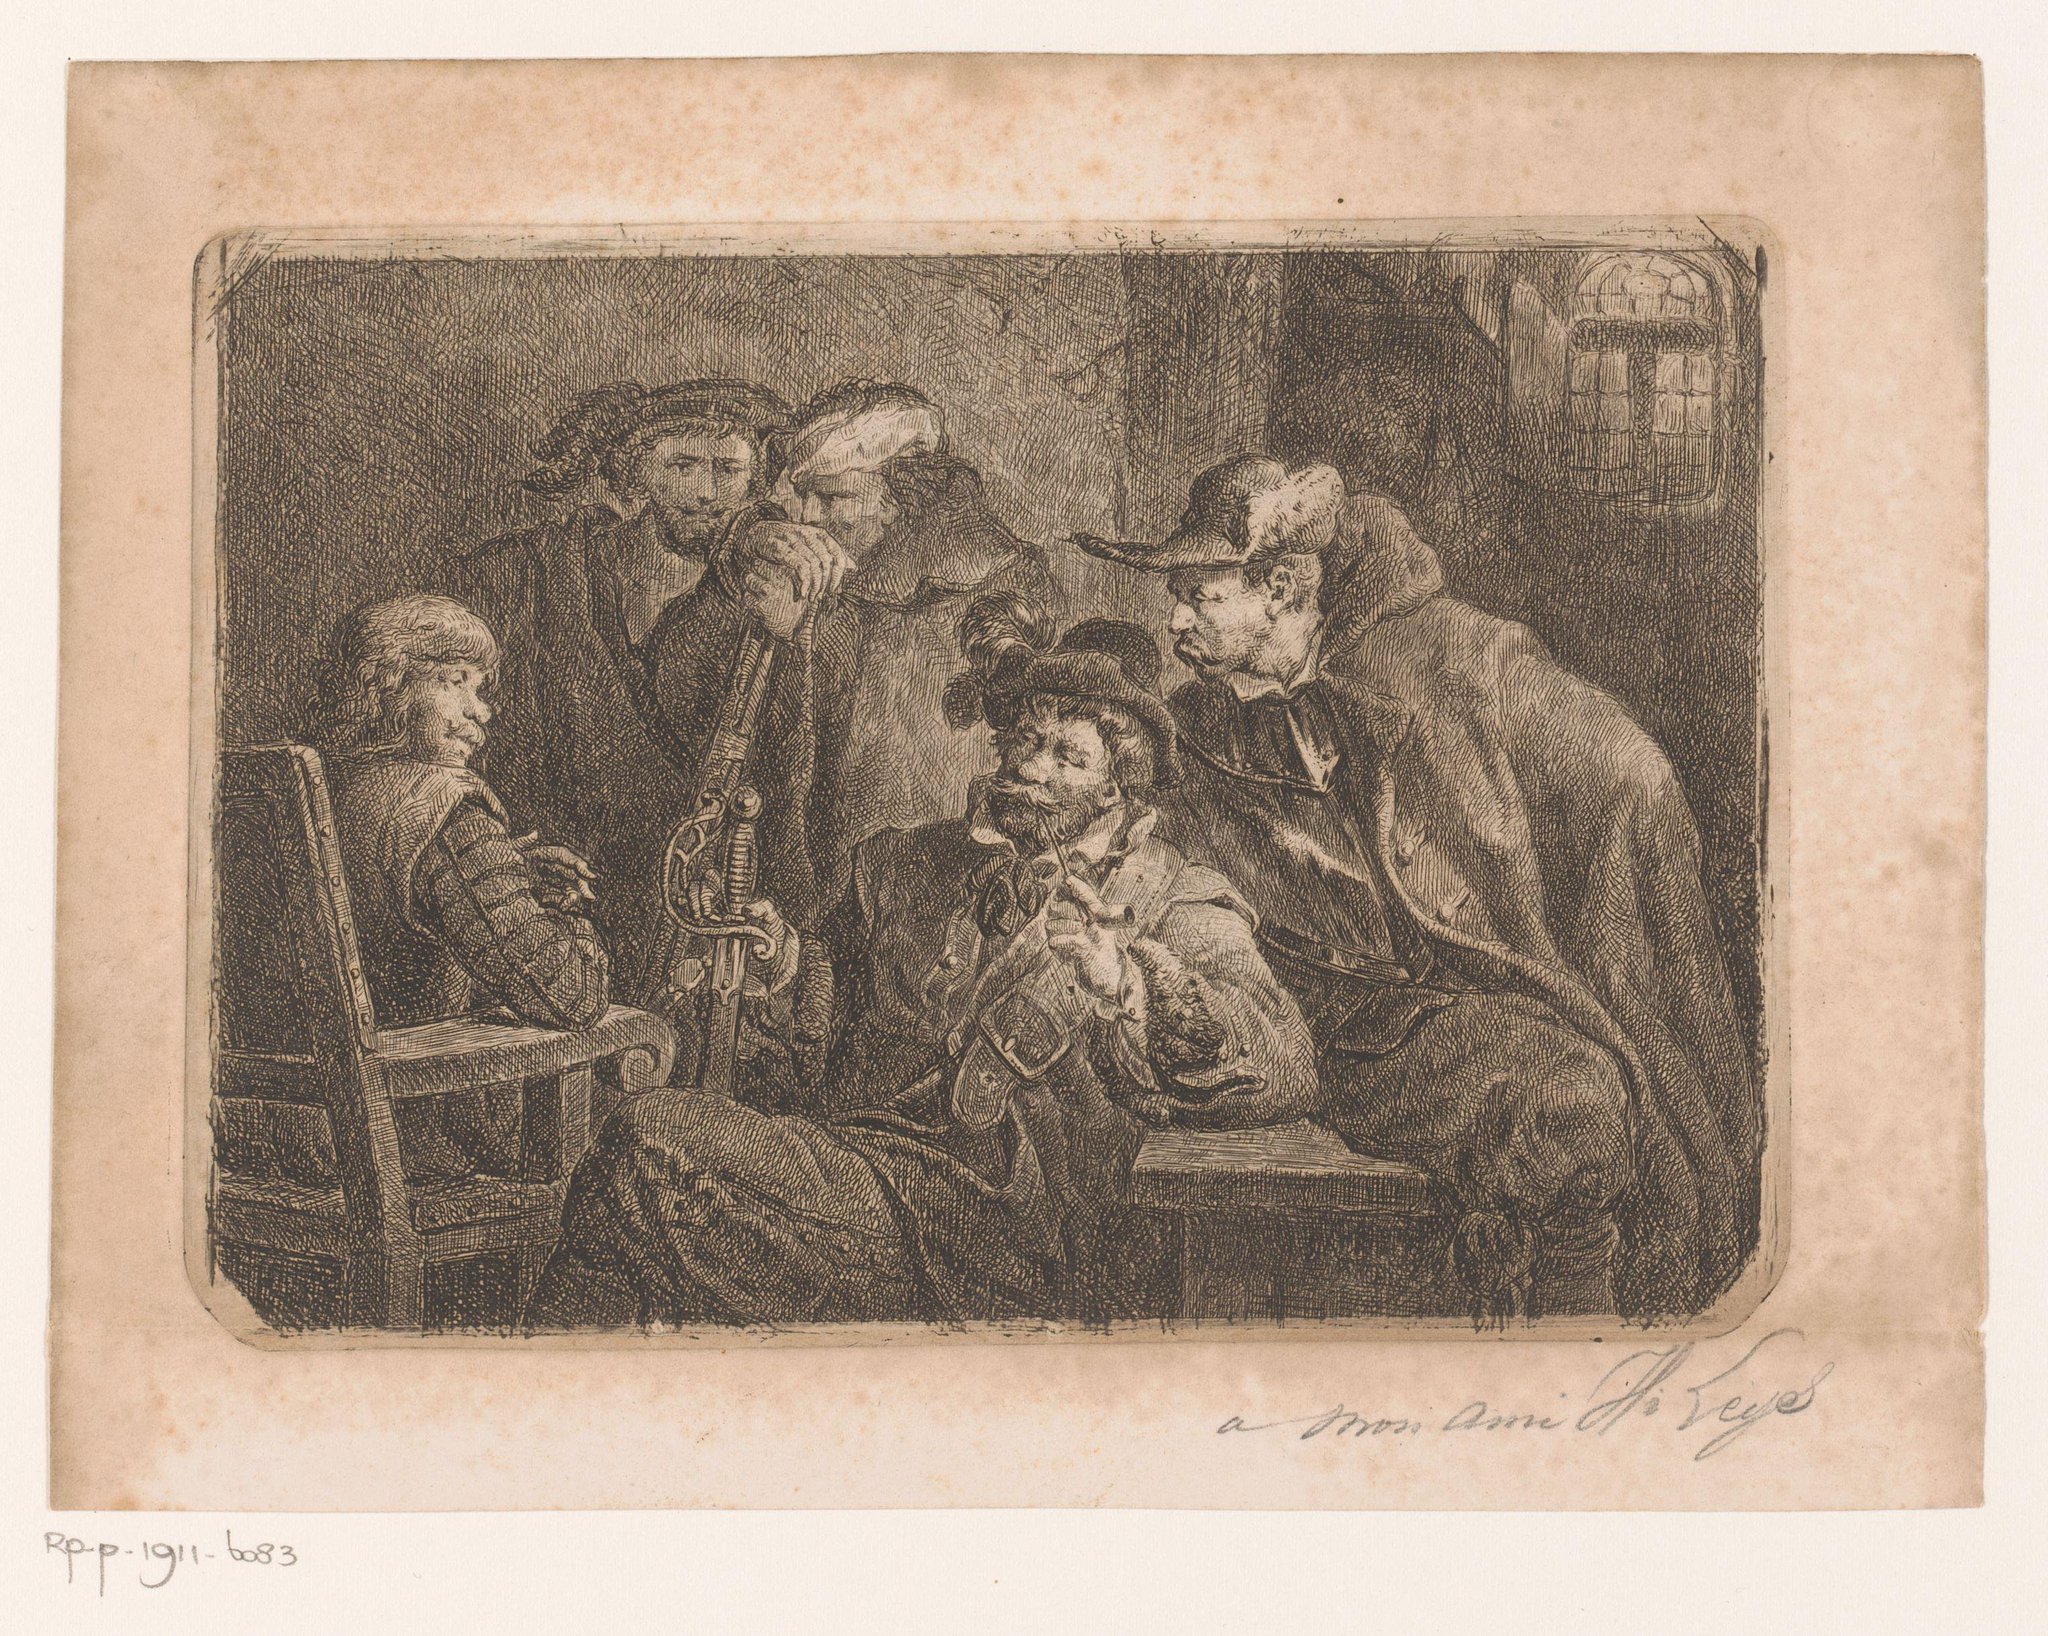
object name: print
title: Vijf soldaten in een wachthuis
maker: joseph lies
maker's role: painter, print maker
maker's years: 1821-1865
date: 1831-1865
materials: paper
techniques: etching, intaglio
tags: in the guard-room, 'kortegaard'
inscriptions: collector's mark: Lugt 2228, dedication: ‘a mon ami H. Leys’